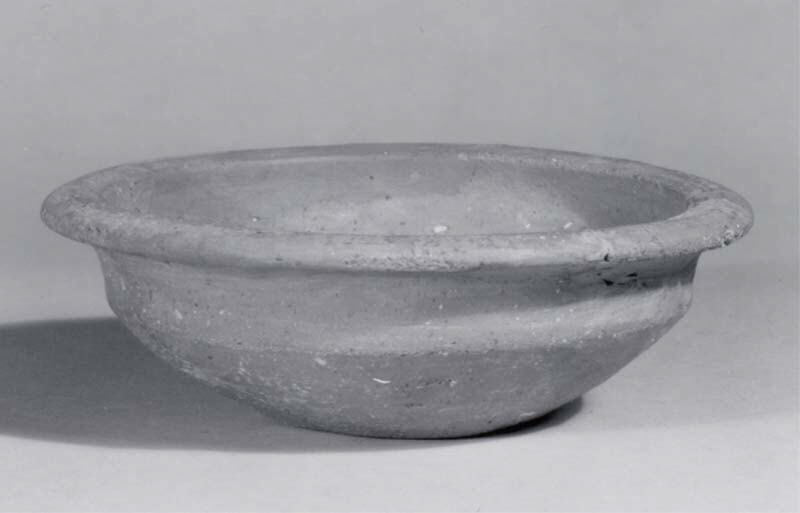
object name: bowl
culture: iranian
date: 700-401 BCE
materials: ceramic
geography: iran